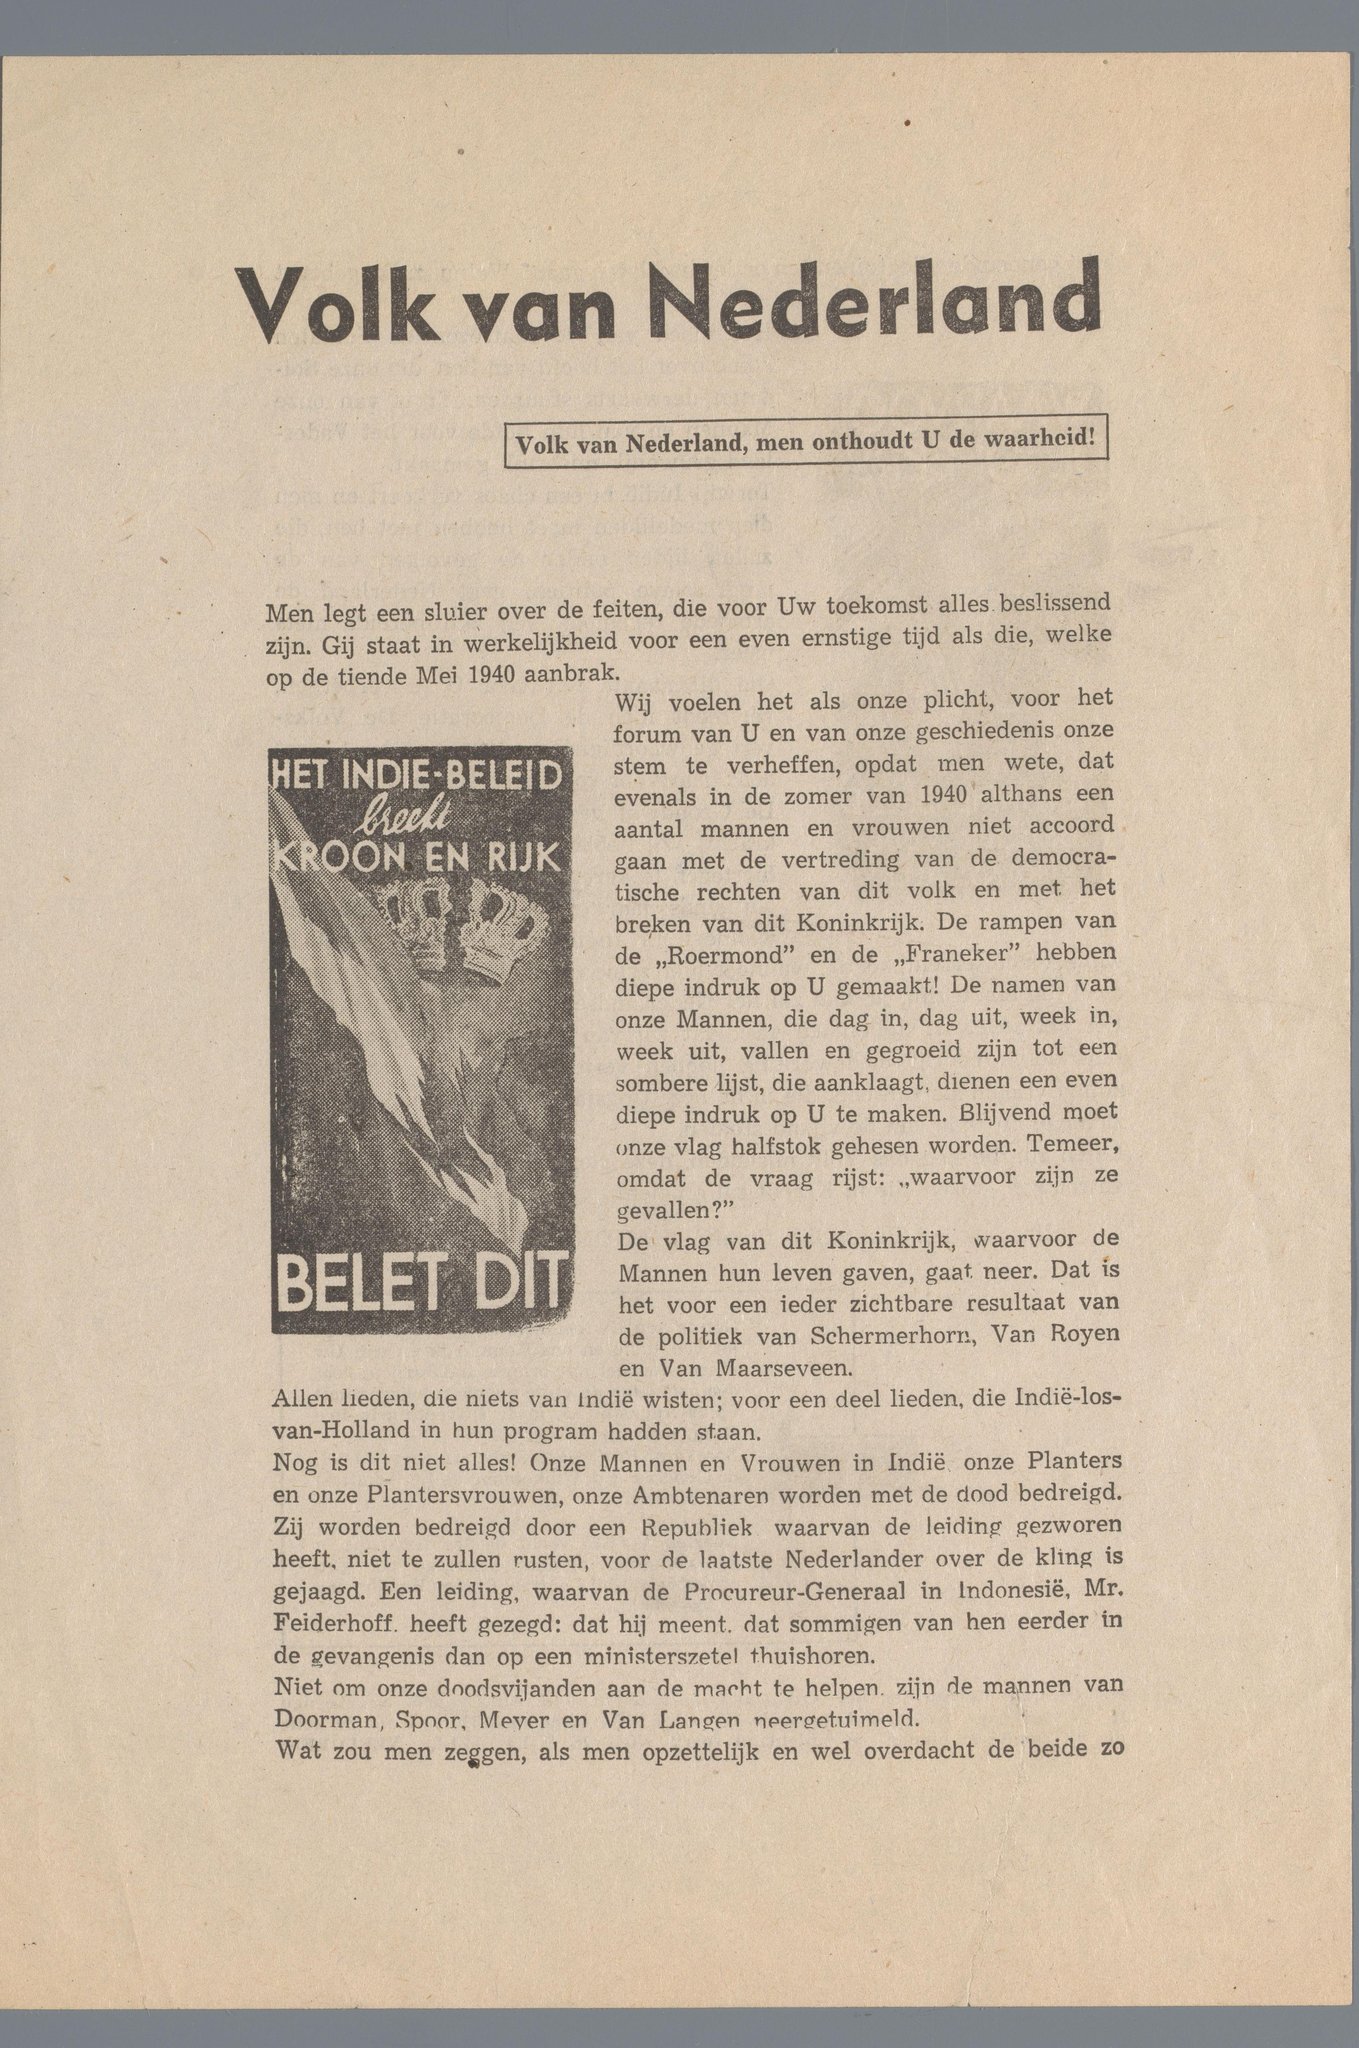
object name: folder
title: Volk van Nederland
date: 1947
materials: paper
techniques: printing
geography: the hague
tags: nationaal comite handhaving rijkseenheid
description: Folder van het nationaal Comite Rijkseenheid. Tweezijdig bedrukt blad papier, met oa. een oproep voor een demonstratieve bijeenkomst.